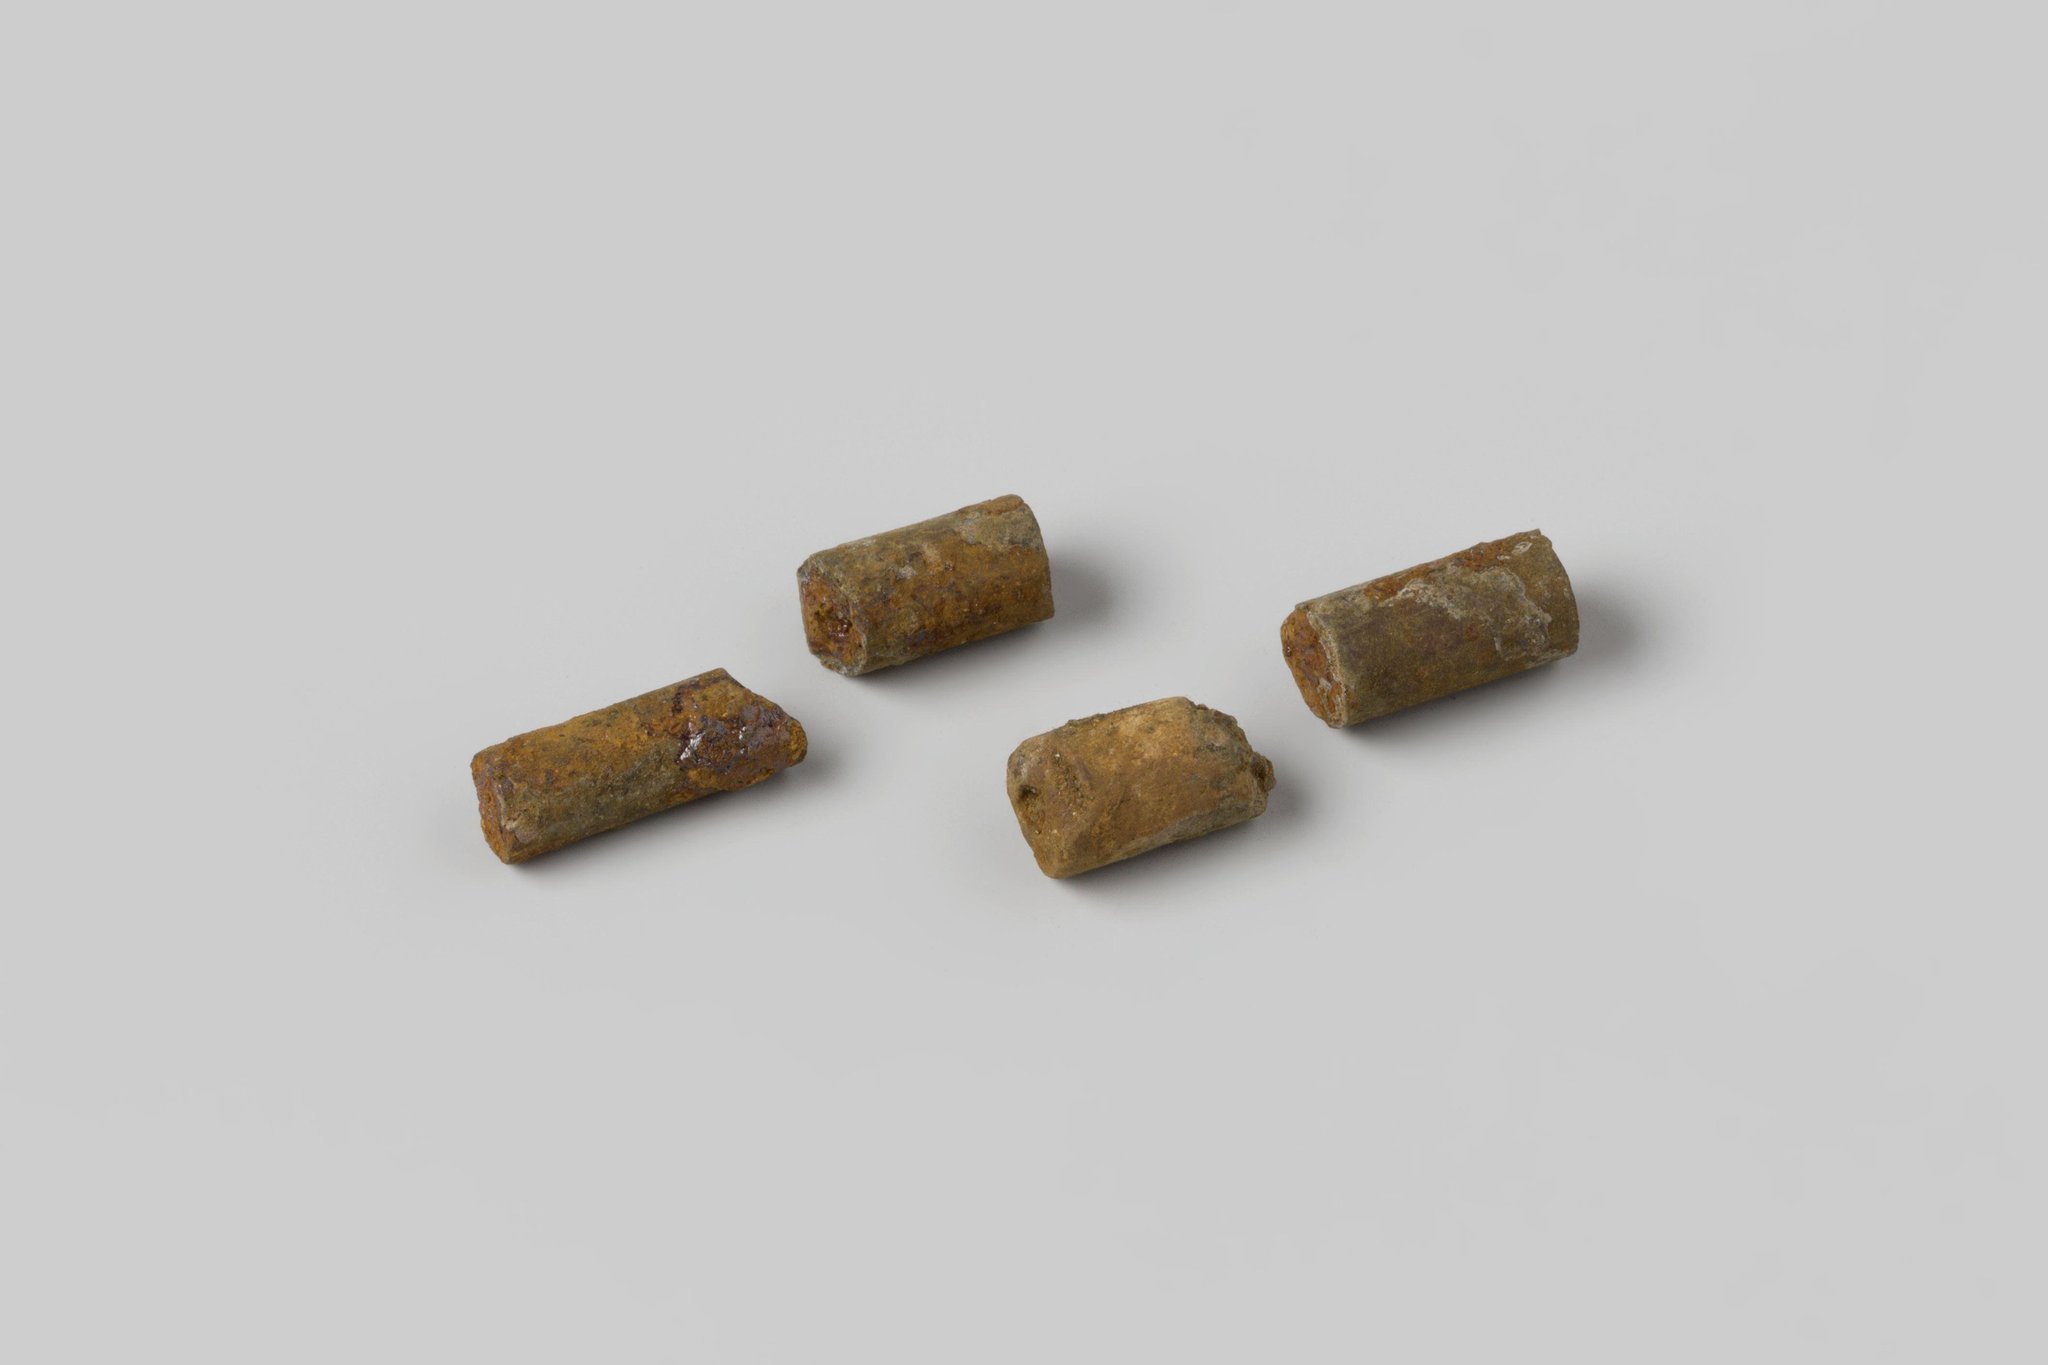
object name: pipe stem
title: Fragmenten pijpenstelen uit het wrak van de Oost-Indiëvaarder Hollandia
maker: Anonymous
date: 1700-1743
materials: clay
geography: netherlands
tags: verenigde oostindische compagnie, hollandia (schip), annet